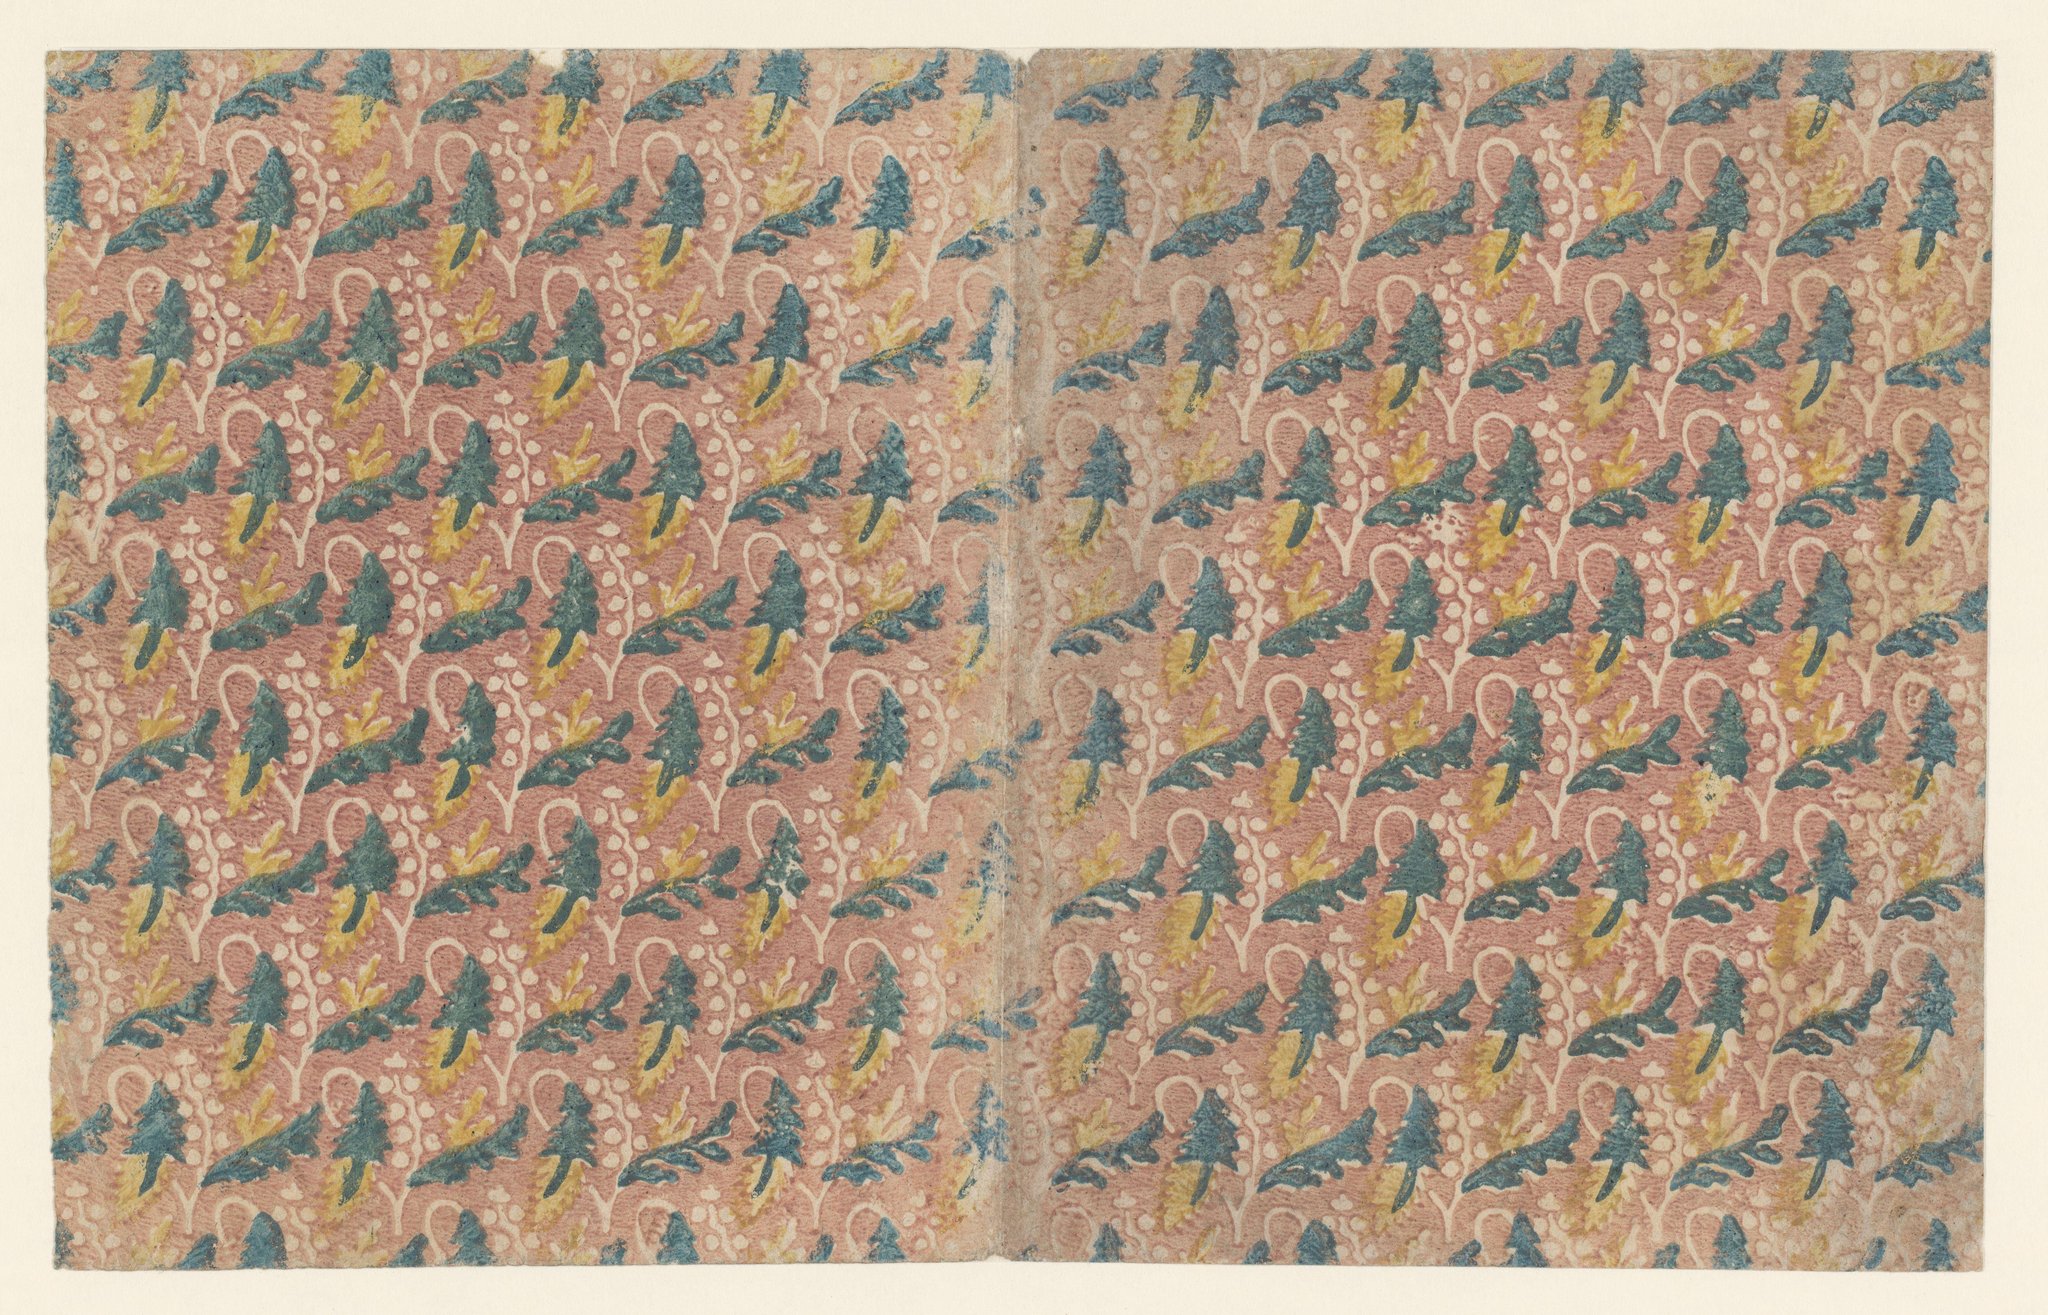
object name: printed paper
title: Blad met alternerend strooipatroon van bladmotieven over tak met vruchten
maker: Anonymous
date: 1700-1850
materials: paper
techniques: printing block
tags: ornament derived from plant forms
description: Blad met alternerend strooipatroon van twee bladmotieven over uitgespaarde tak met vruchten. Gebruikt als omslag.